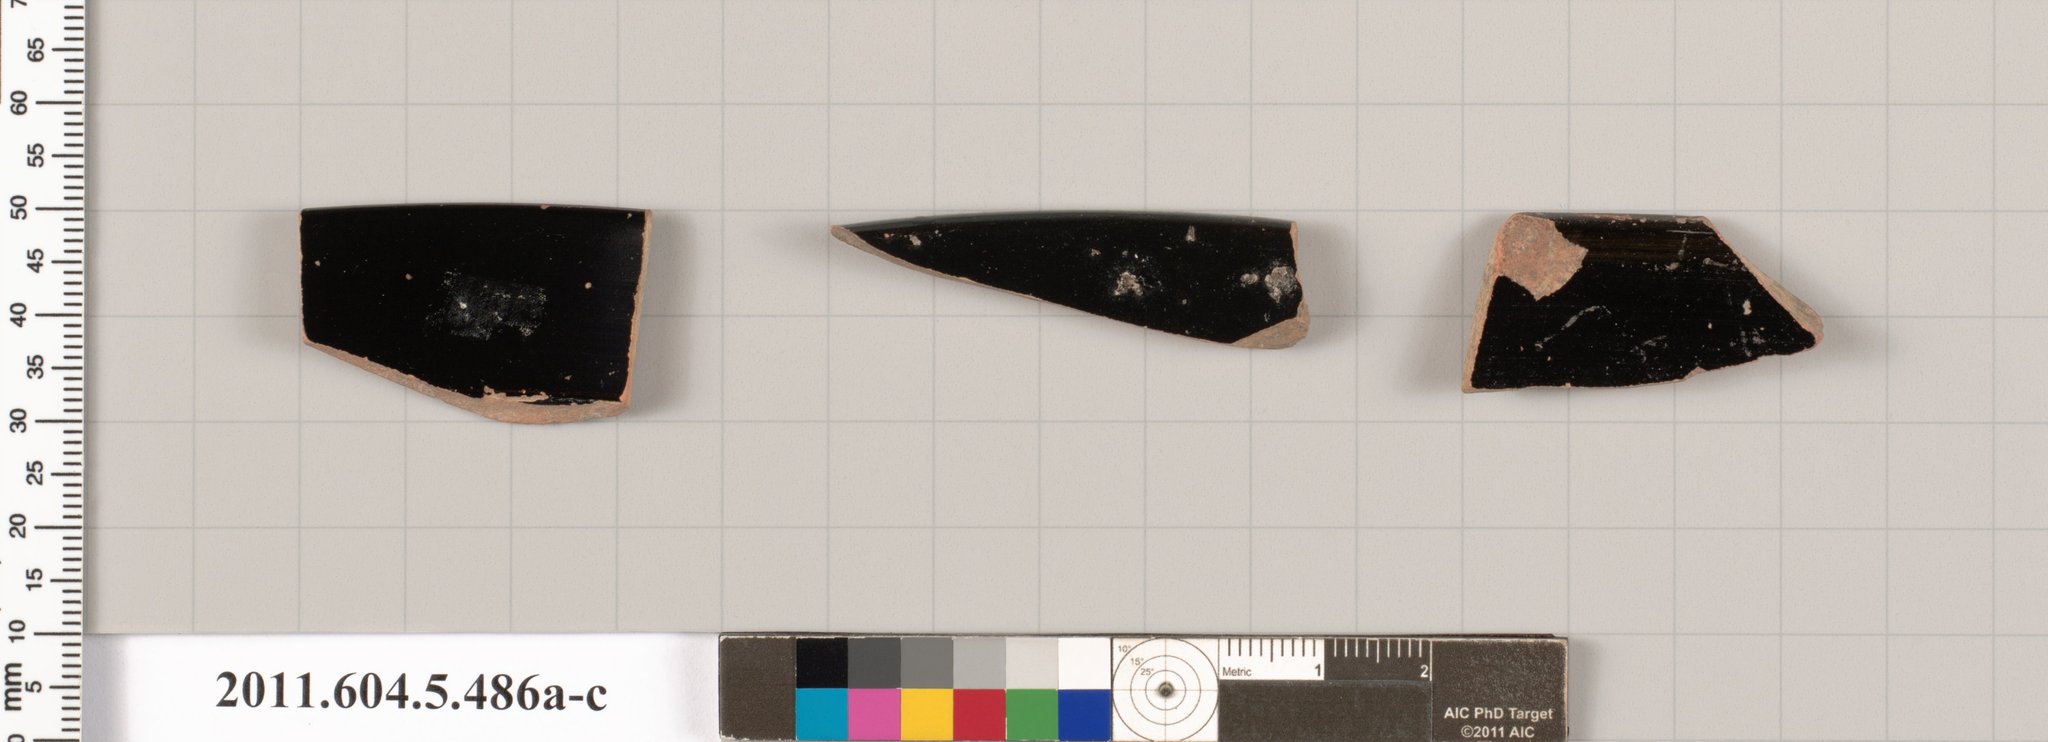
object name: kylix fragment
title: Terracotta rim fragments of kylikes (drinking cups)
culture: greek, attic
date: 600-401 BCE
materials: terracotta